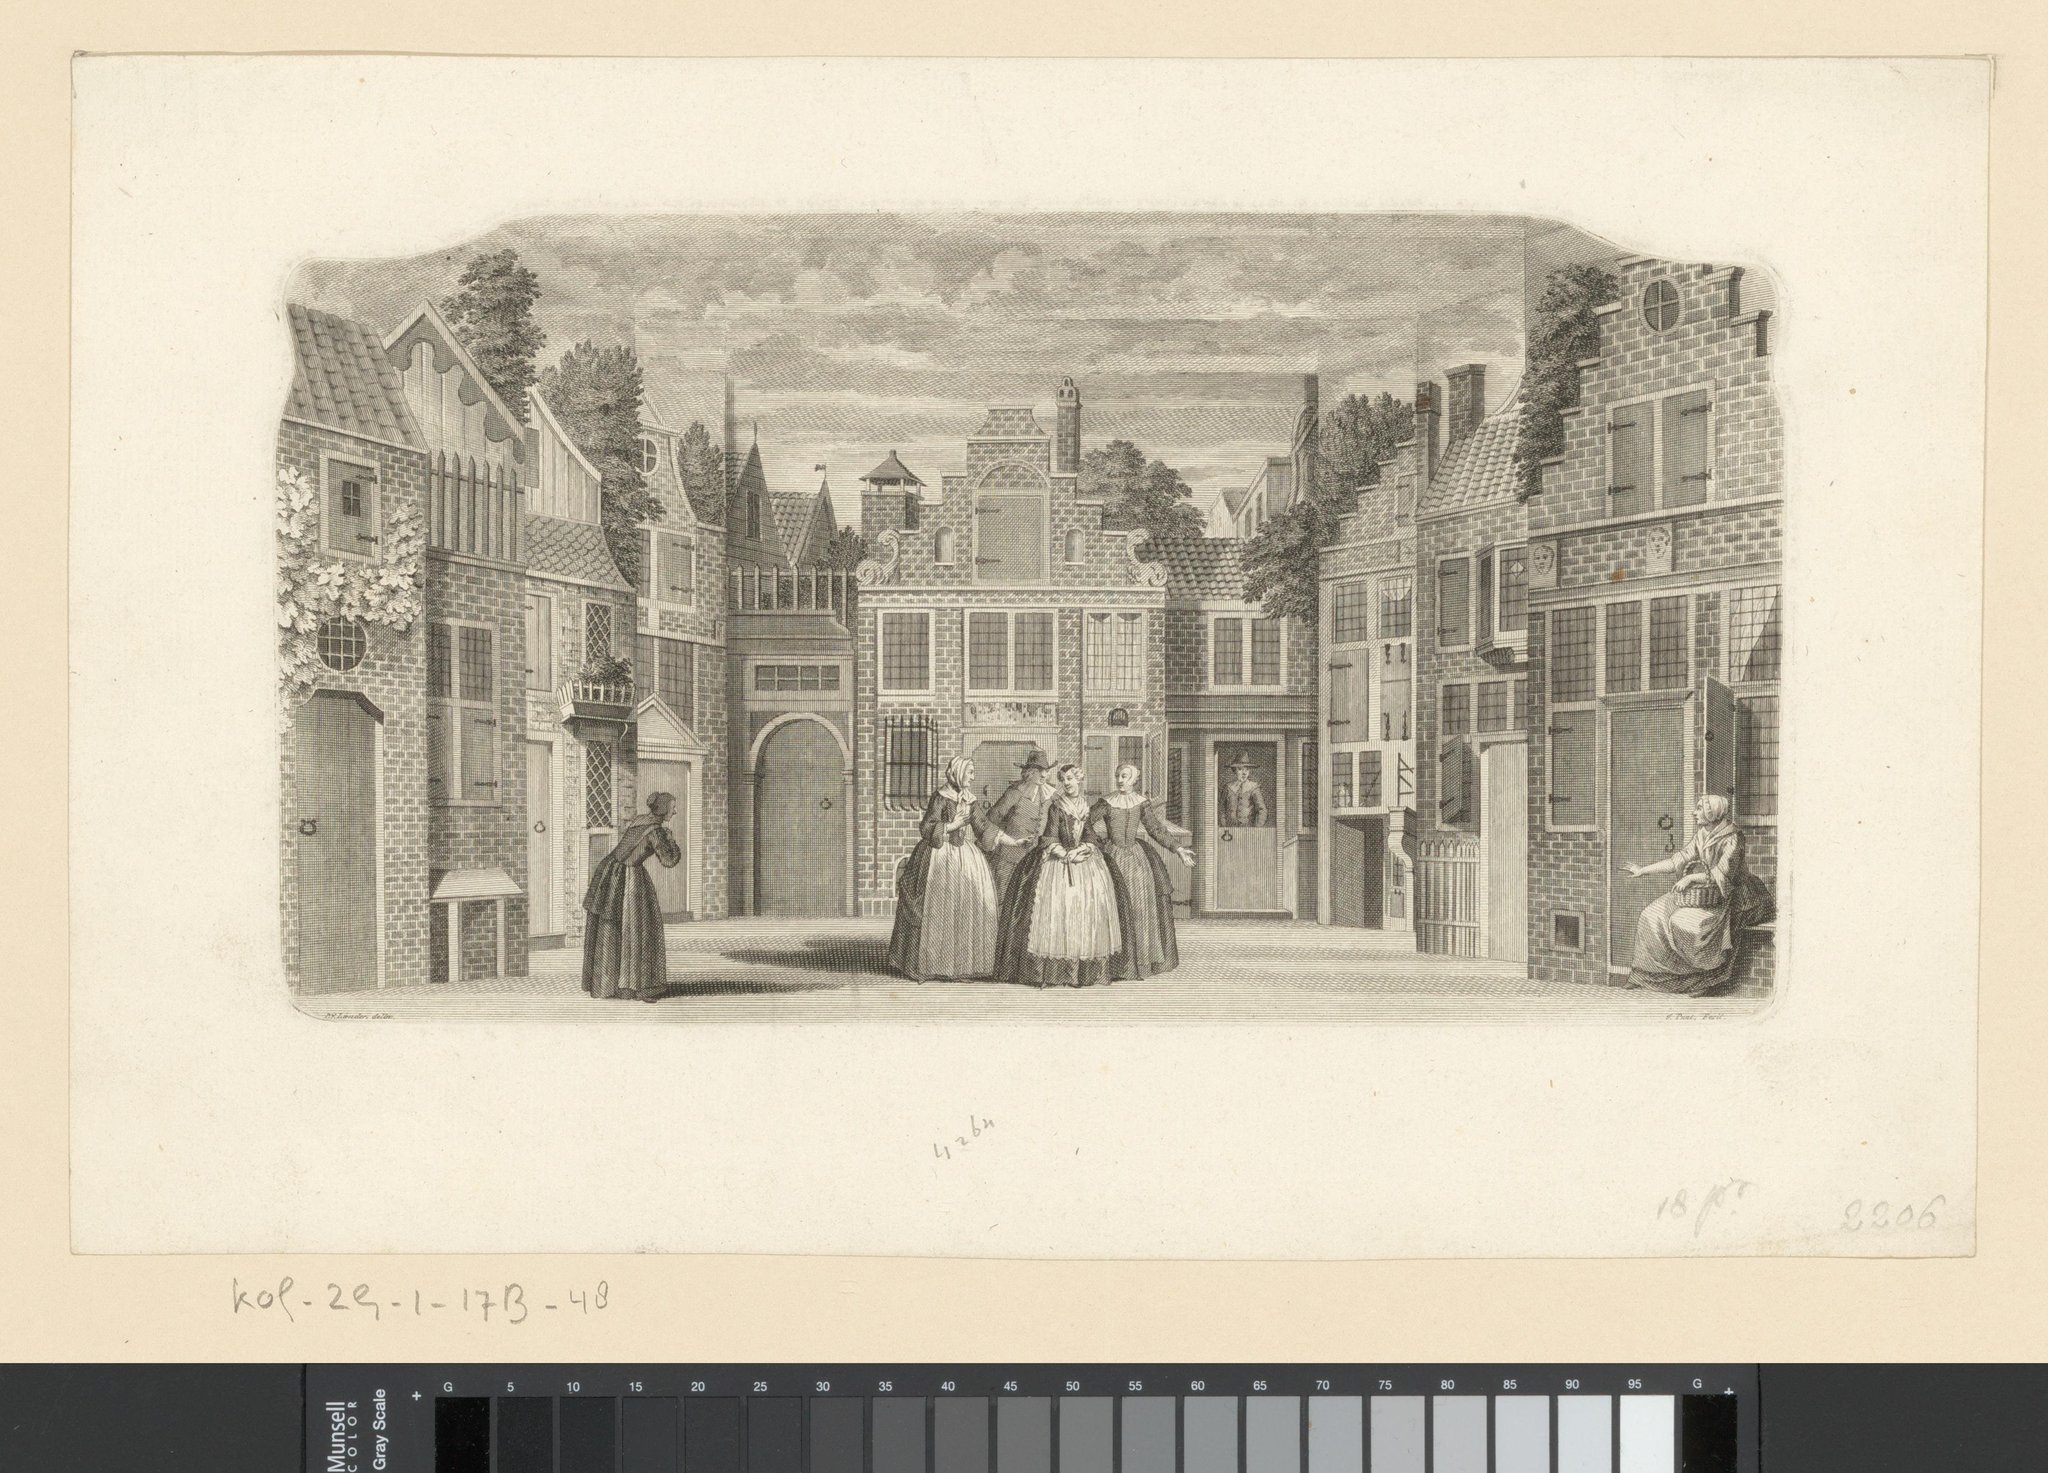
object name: print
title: Toneeldecors van de Amsterdamse Schouwburg, ca. 1760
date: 1760-1765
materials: paper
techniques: engraving, etching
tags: theatre, theatrical performance, stage design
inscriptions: stamp, collector's mark: Lugt 1641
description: Het coulissendecor De Gemeene Buurt met scène uit: Het Verliefde Brechje. Alleen het decor gedrukt van een aparte plaat, dus zonder het passe-partout. Onderdeel van een serie van twaalf toneeldecors van de Amsterdamse Schouwburg op de Keizersgracht. Onderwerpsrubrieken binnen de Atlas Zeden en Gewoonten: Schoone kunsten, Tooneel, Schouwburg op de Keizersgracht (1637 – 1772).